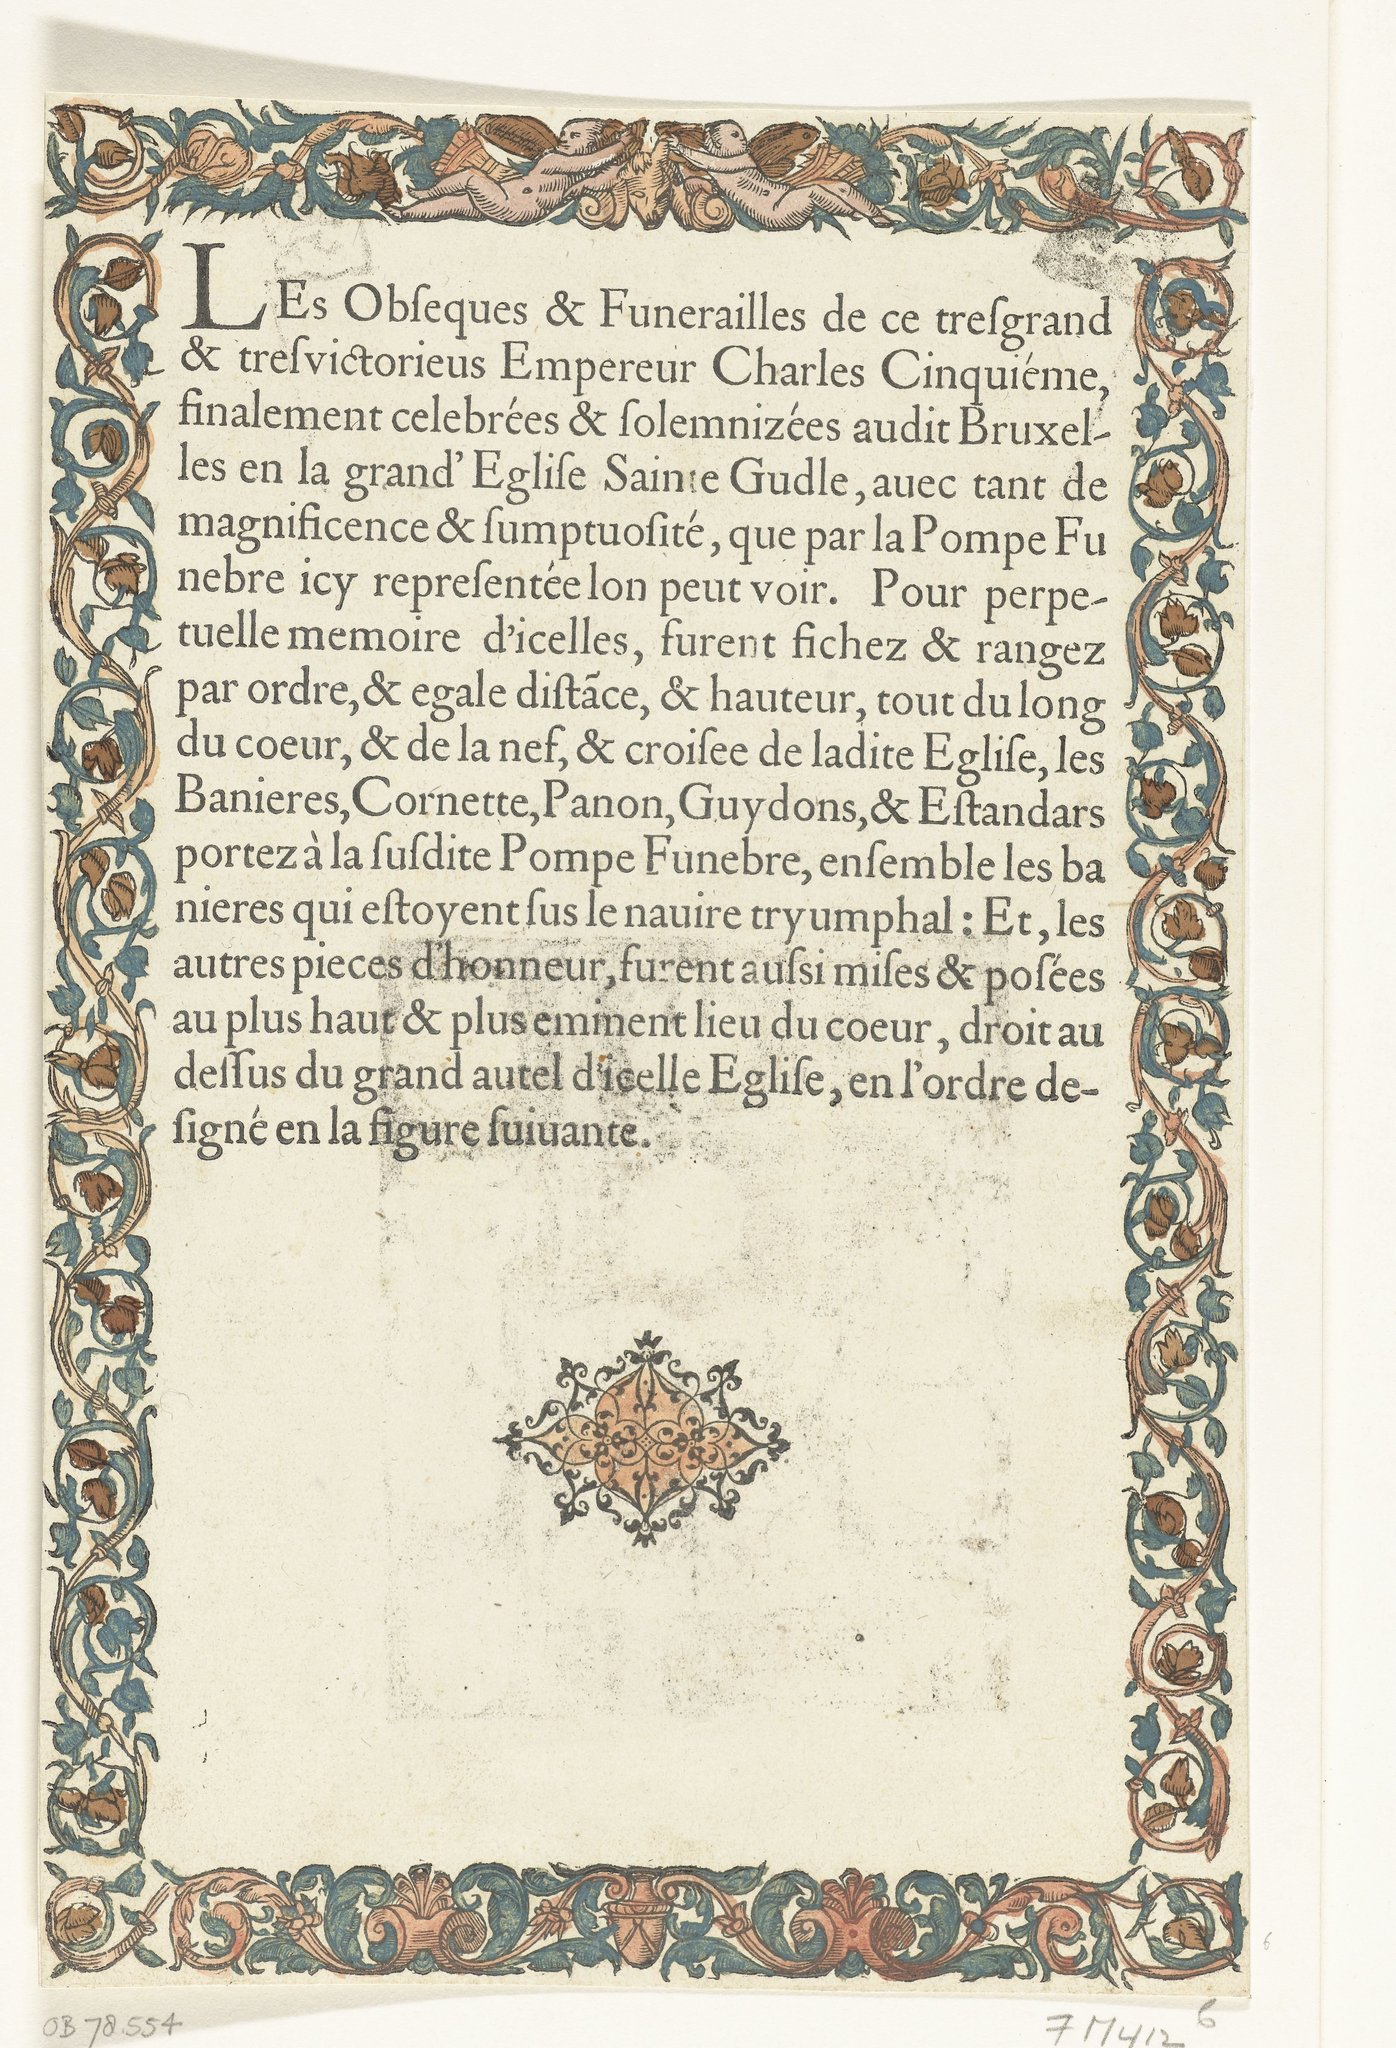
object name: text sheet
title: Begrafenisoptocht van keizer Karel V, 1558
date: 1559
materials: paper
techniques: hand coloring, letterpress printing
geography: antwerp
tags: ghent, charles v (holy roman emperor and king of spain), brussels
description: Tekstblad bij de Begrafenisoptocht van keizer Karel V, 1558. Tekstblad met titel en beschrijving van de optocht. In ornamentele randen in houtsnede. Zesde blad.